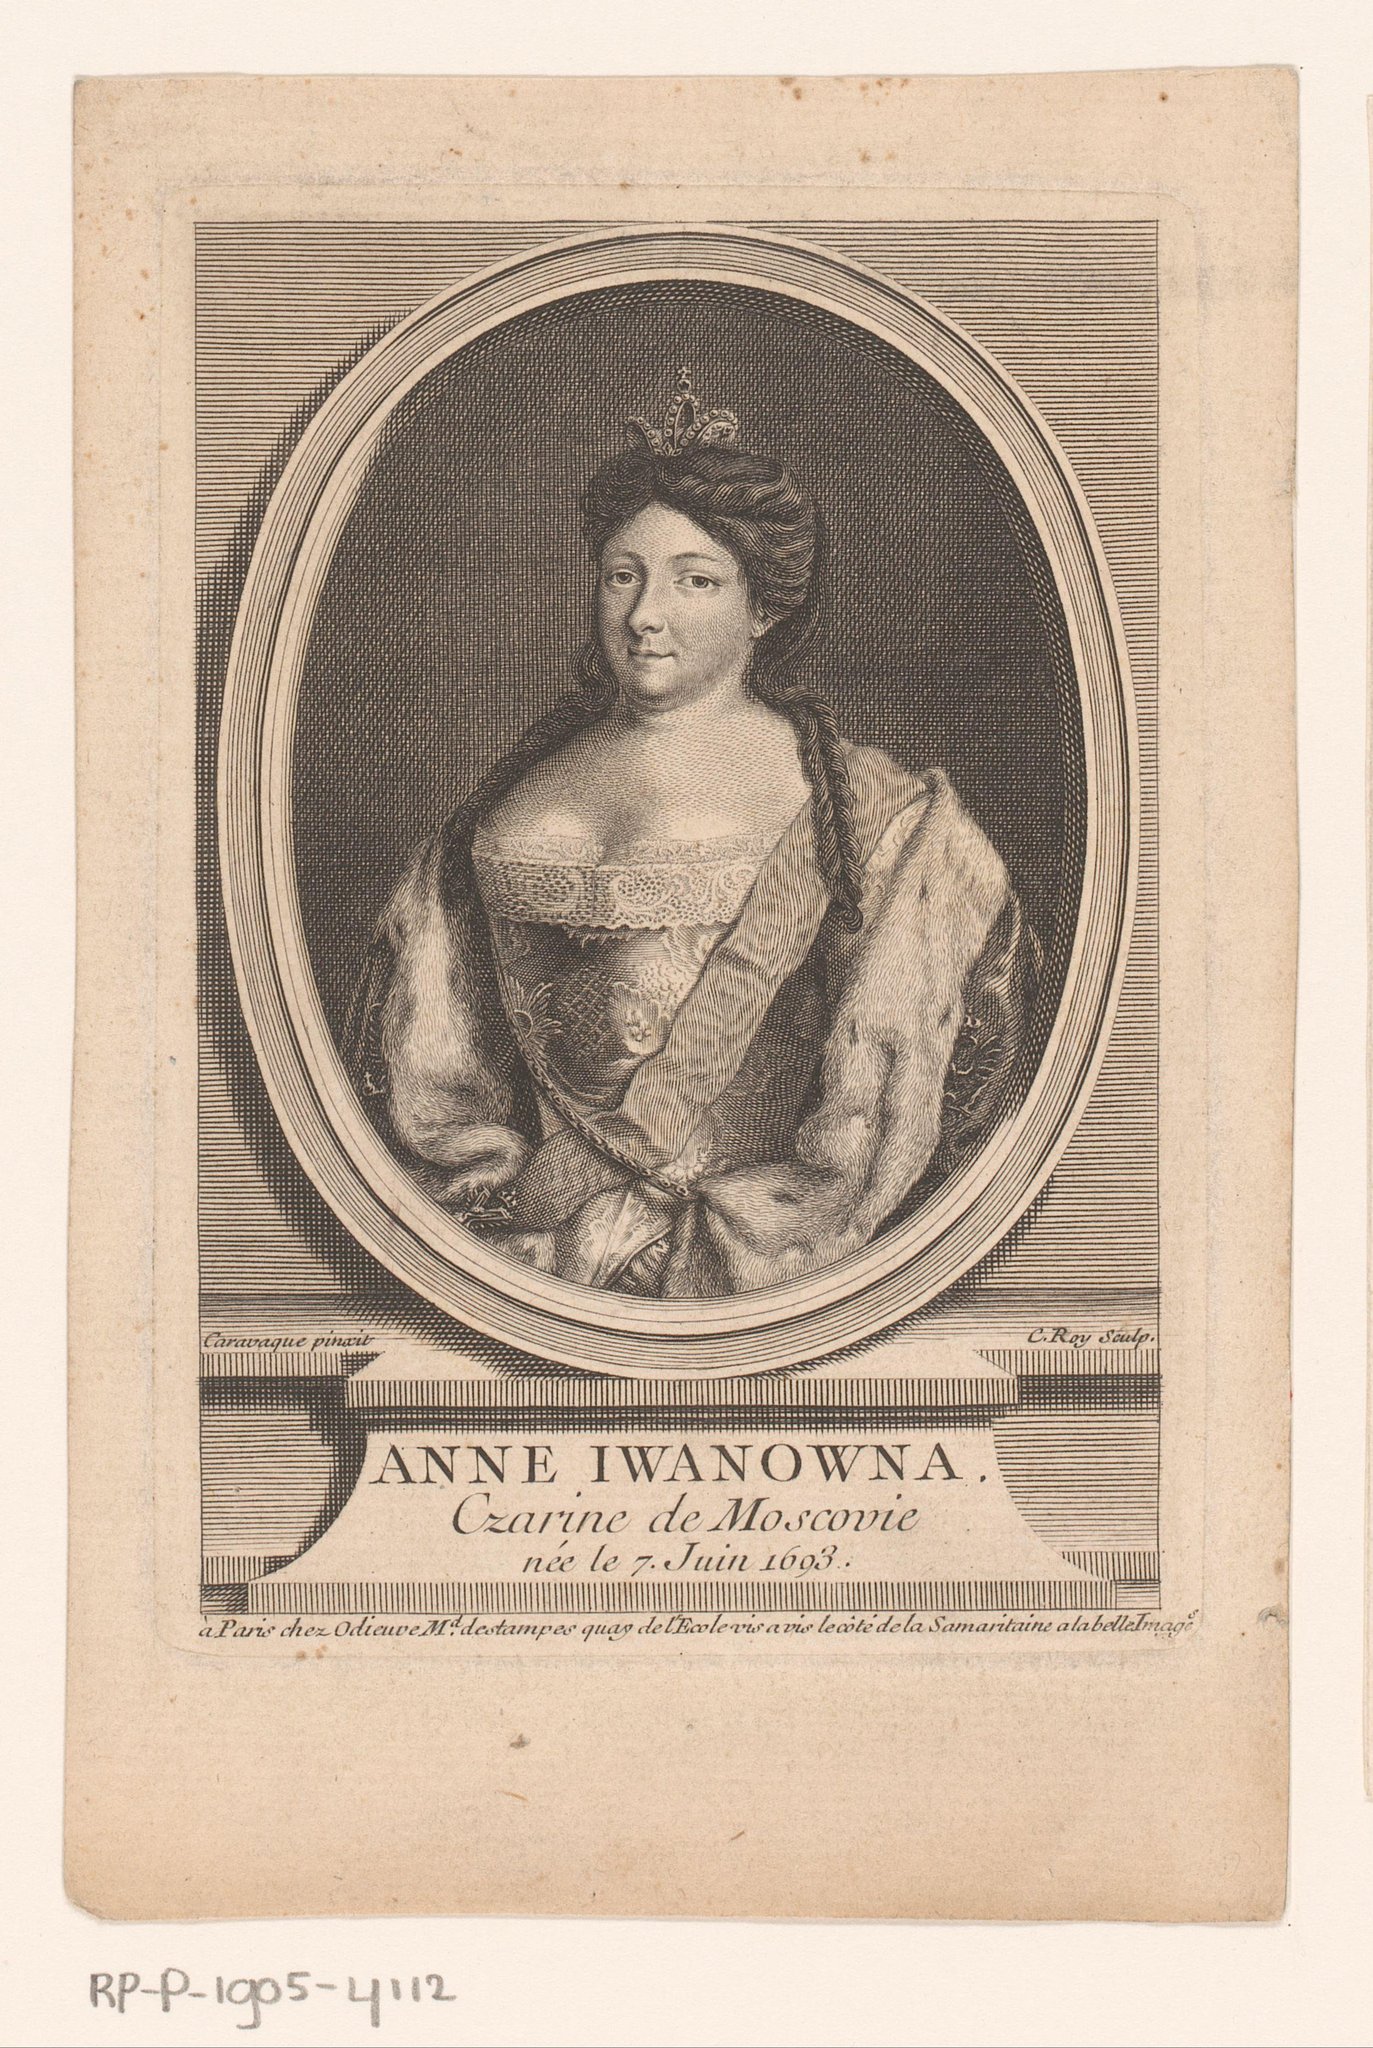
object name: print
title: Portret van Anna Ivanovna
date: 1717-1797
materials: paper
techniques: engraving, etching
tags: historical persons, emperor - bb - female ruler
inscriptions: collector's mark: Lugt 2228